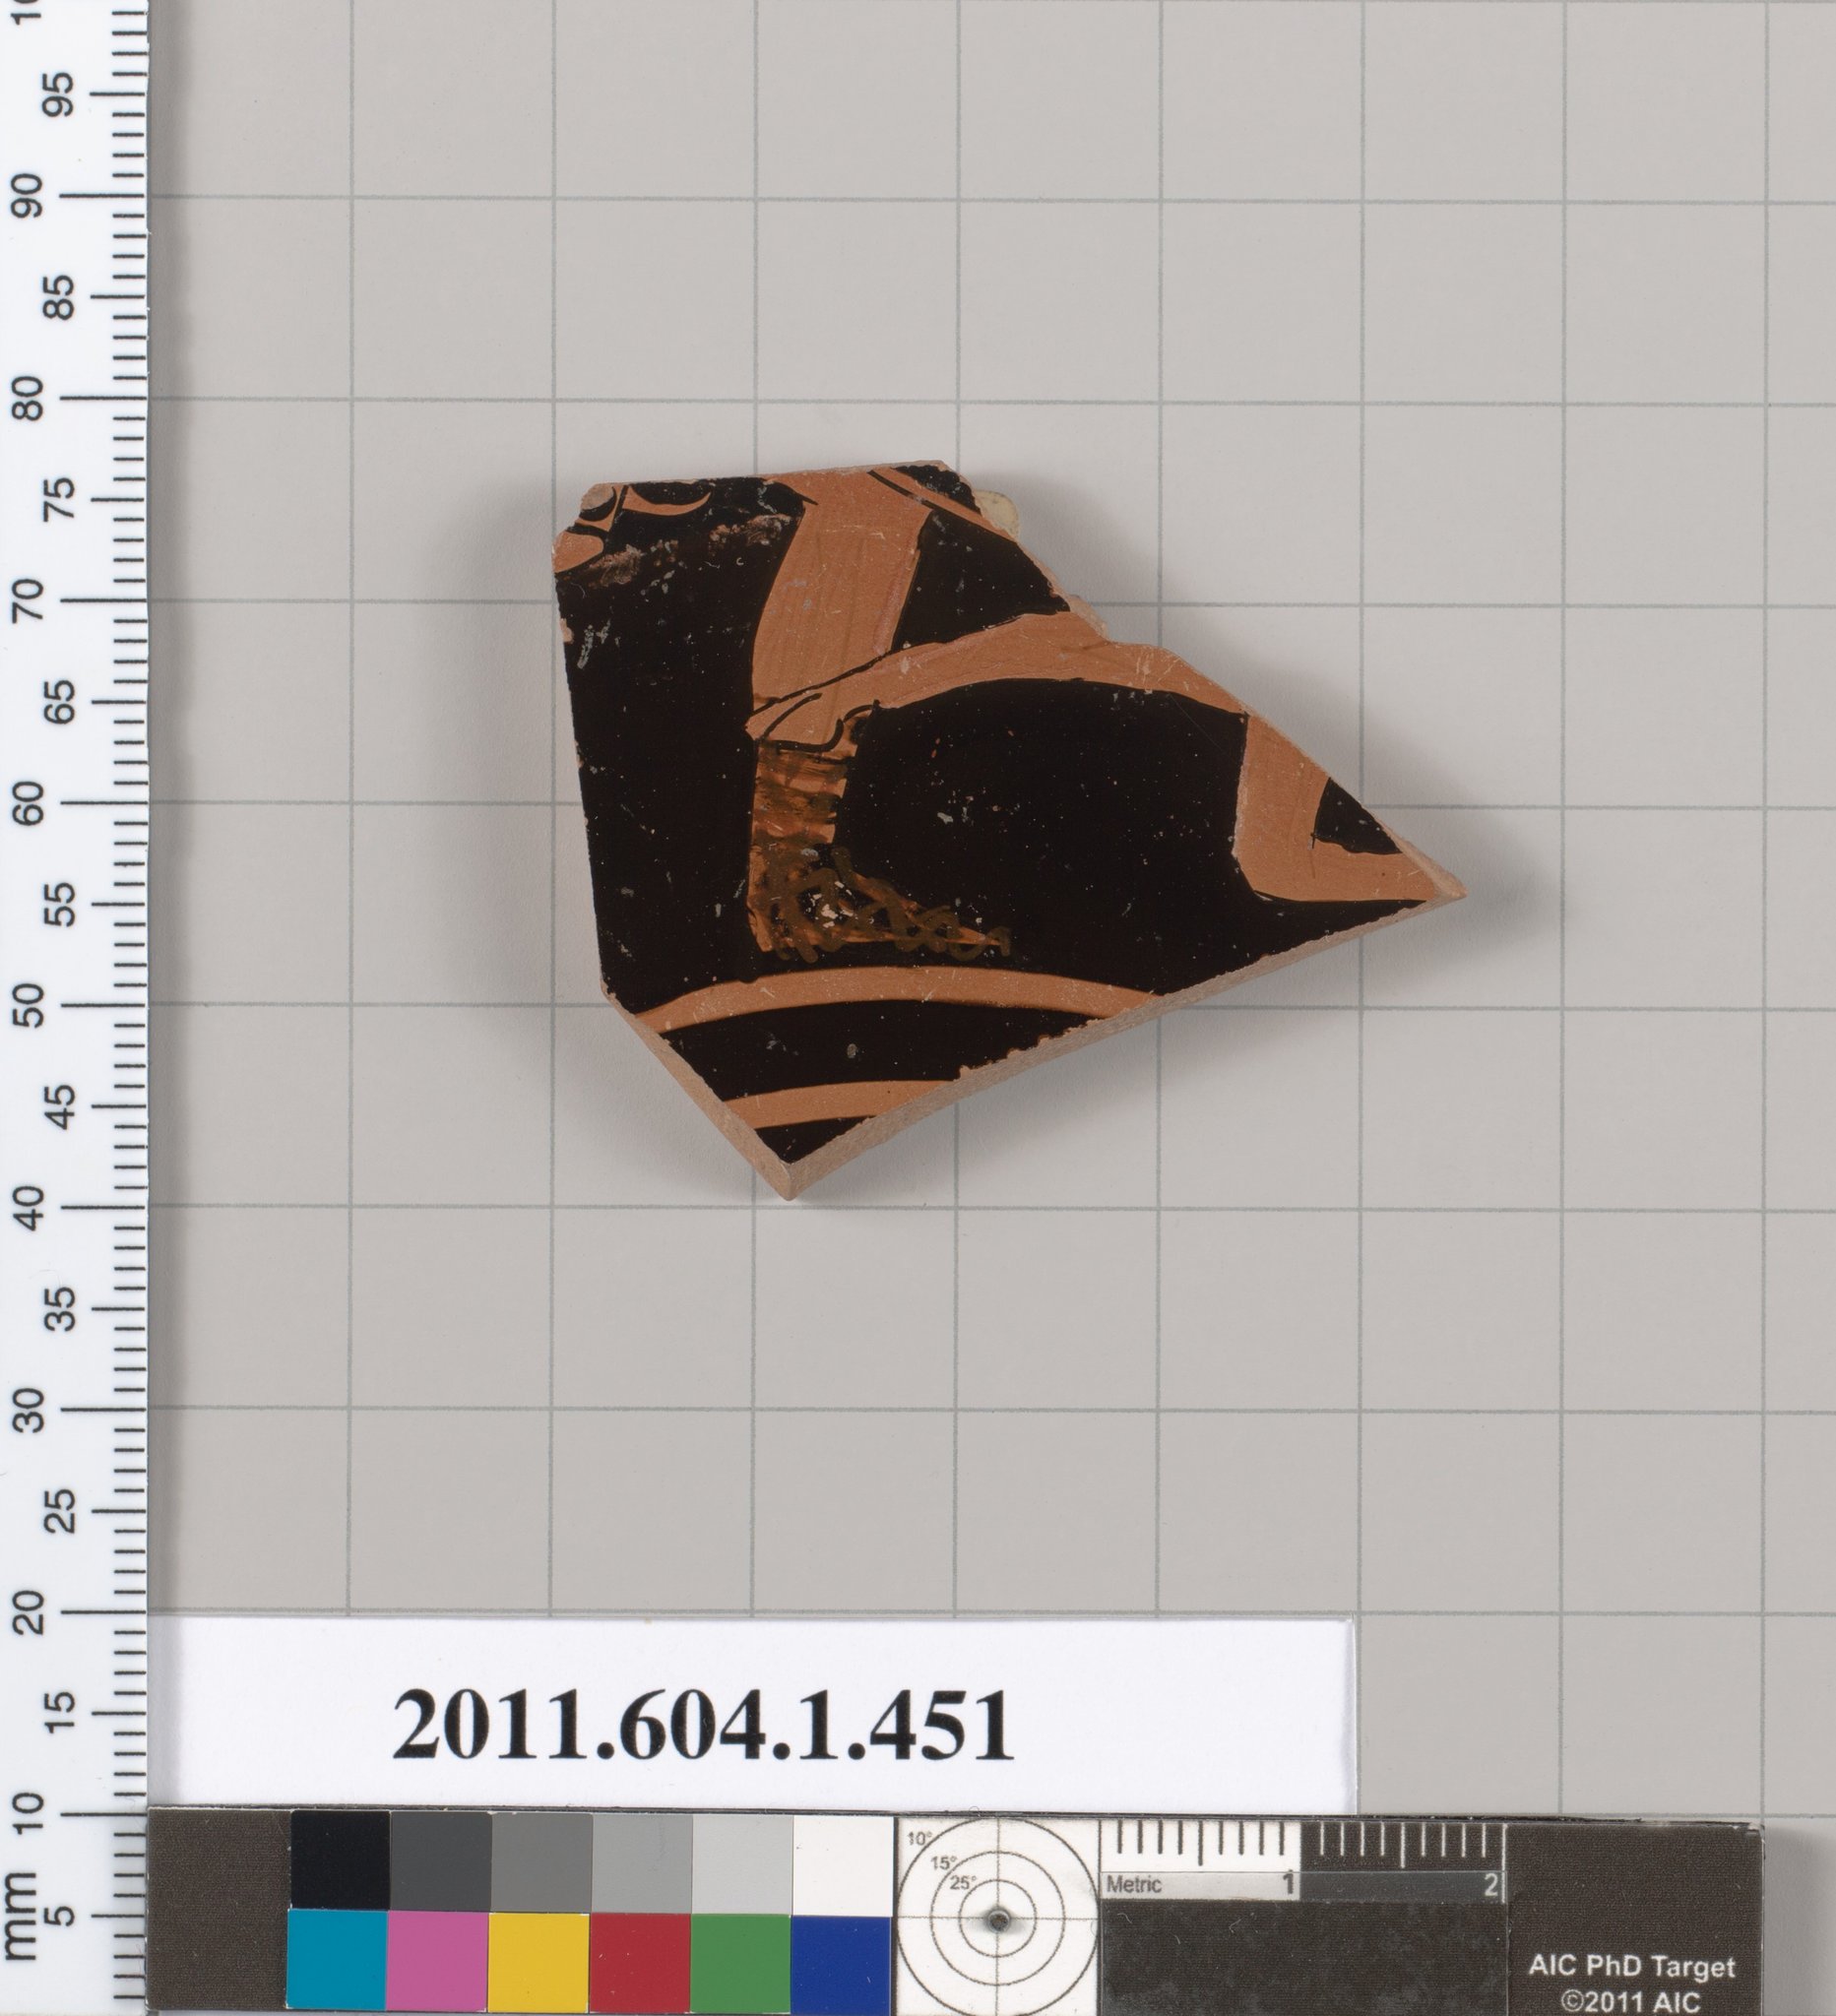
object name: kylix fragment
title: Terracotta fragment of a kylix (drinking cup)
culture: greek, attic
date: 475-451 BCE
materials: terracotta